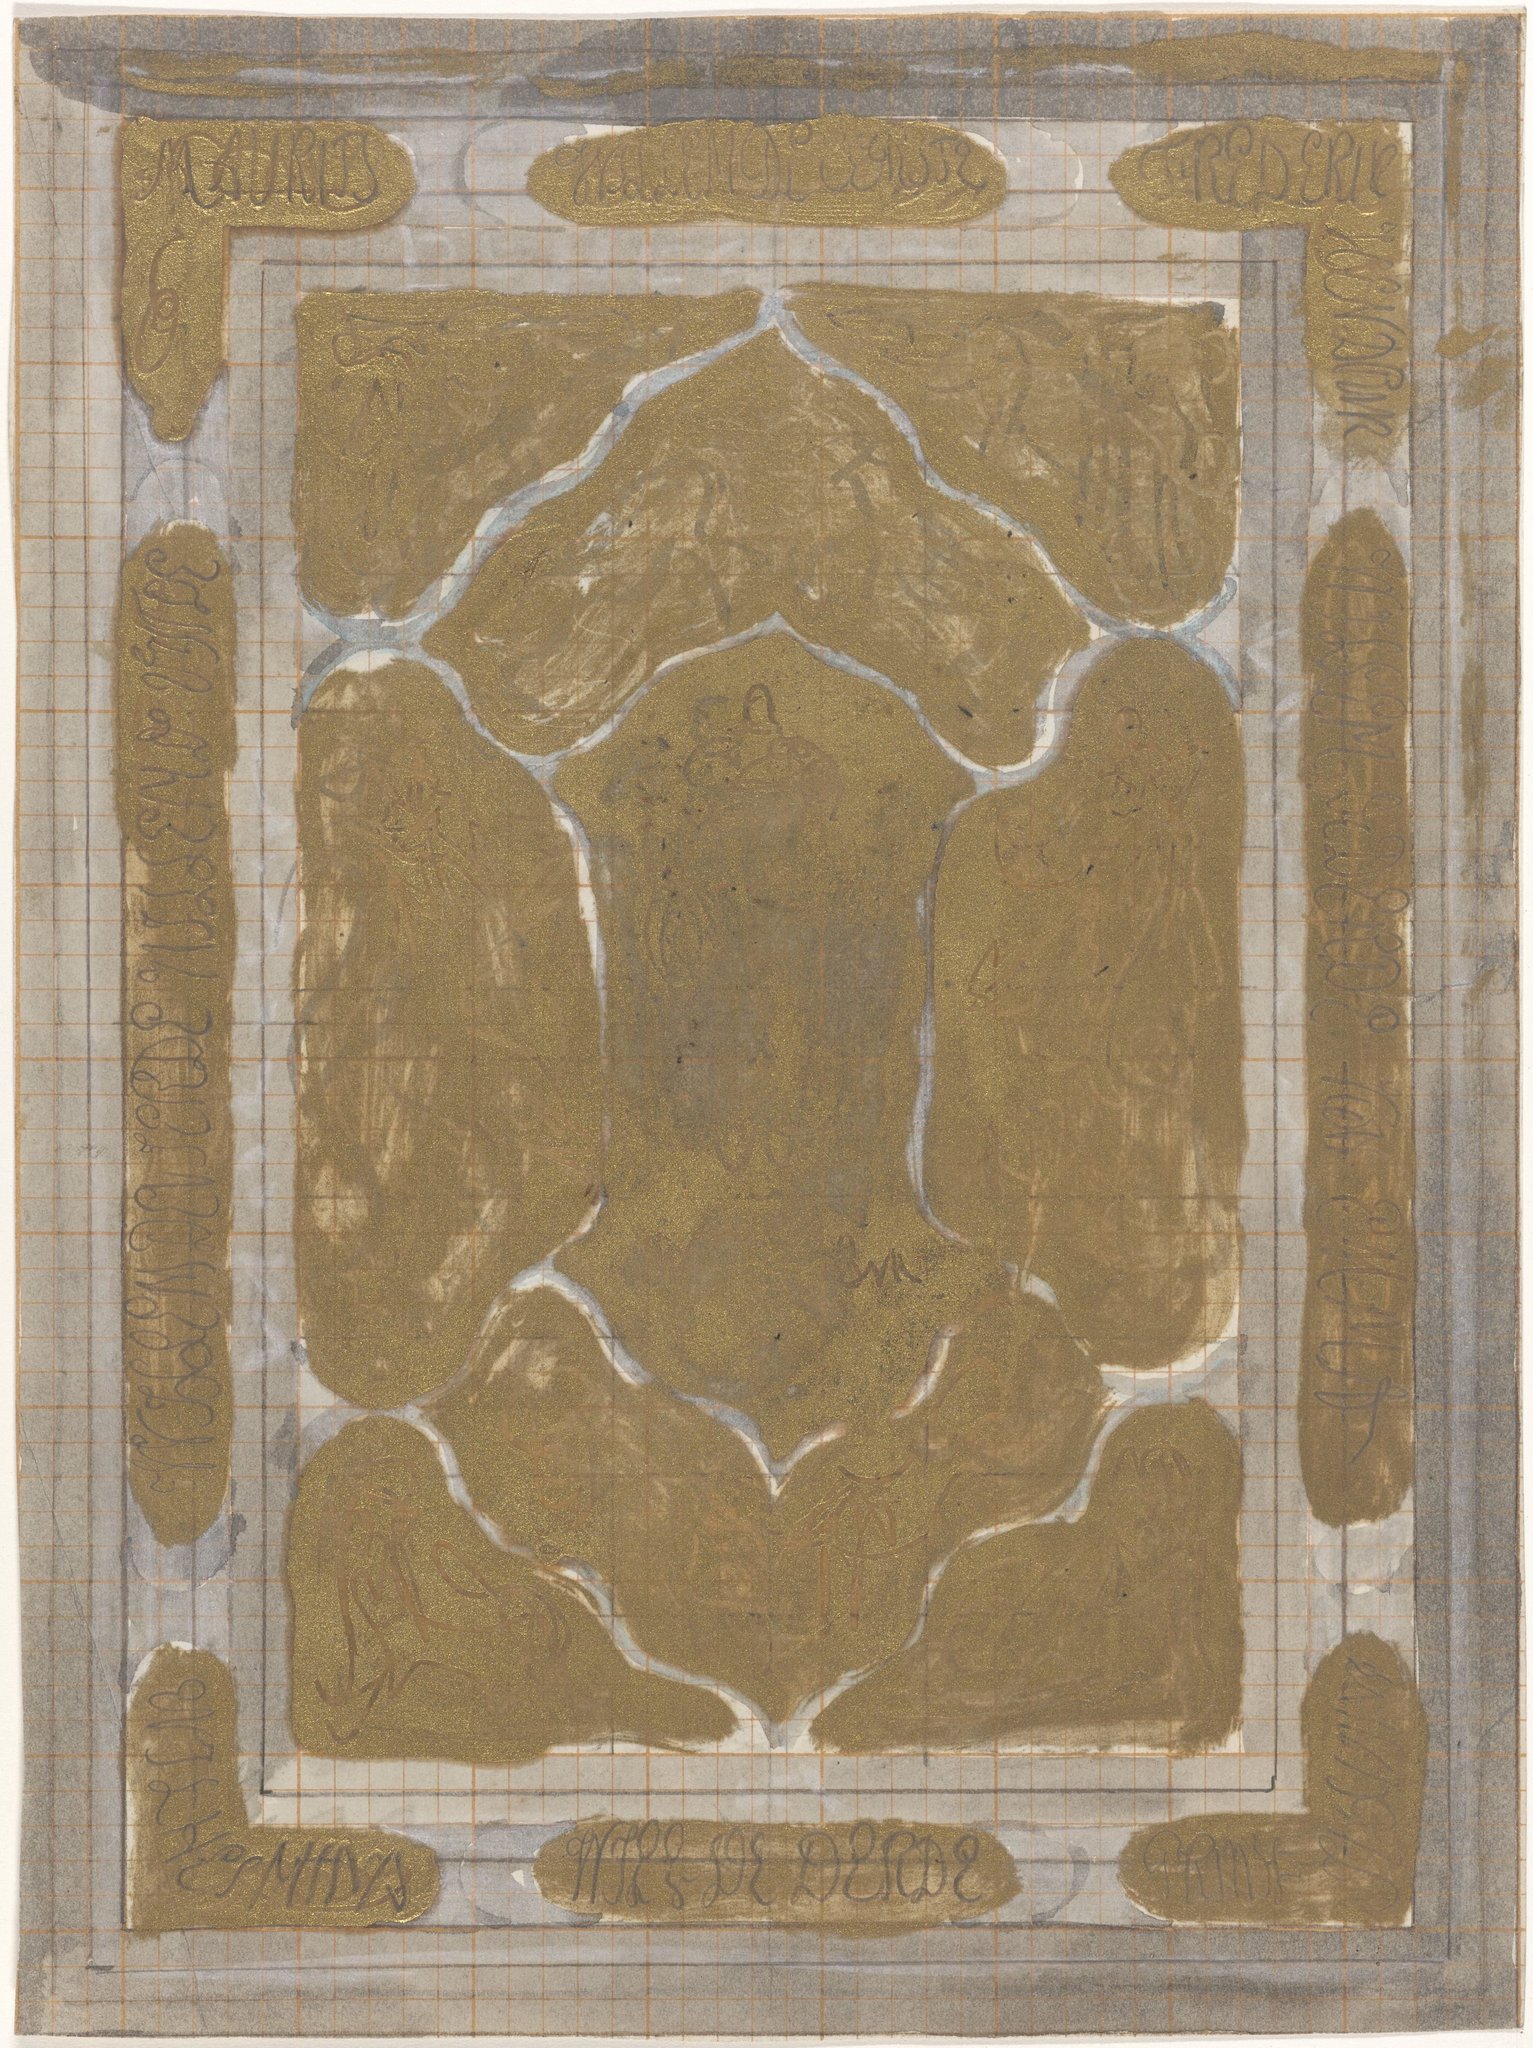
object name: drawing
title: Ontwerp voor boekband voor Oranje gedenkboek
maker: carel adolph lion cachet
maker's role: draughtsman, print maker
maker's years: 1864-1945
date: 1874-1945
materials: paint, pencil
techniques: brush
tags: book-cover, binding